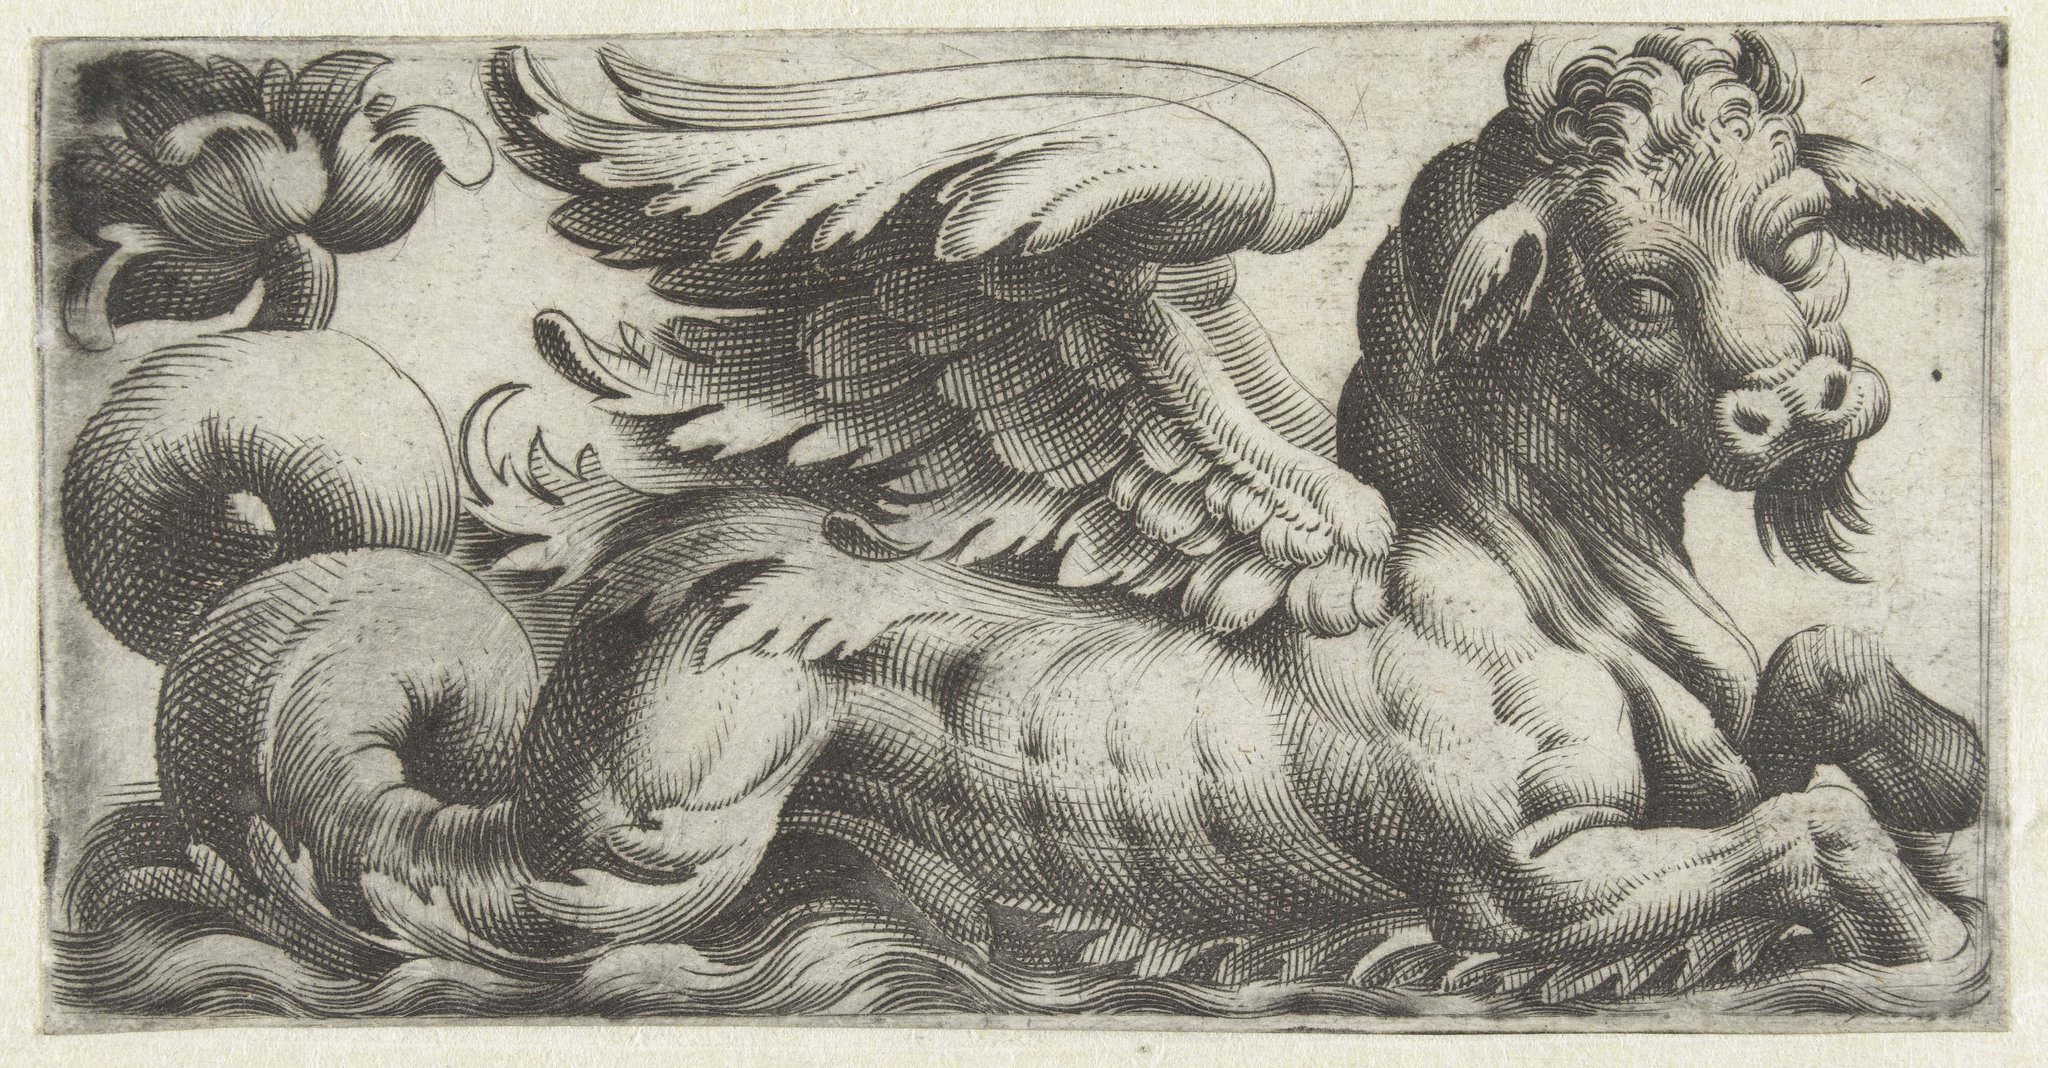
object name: print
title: Gevleugelde zeestier met een sik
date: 1580-1610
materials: paper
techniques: engraving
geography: italy